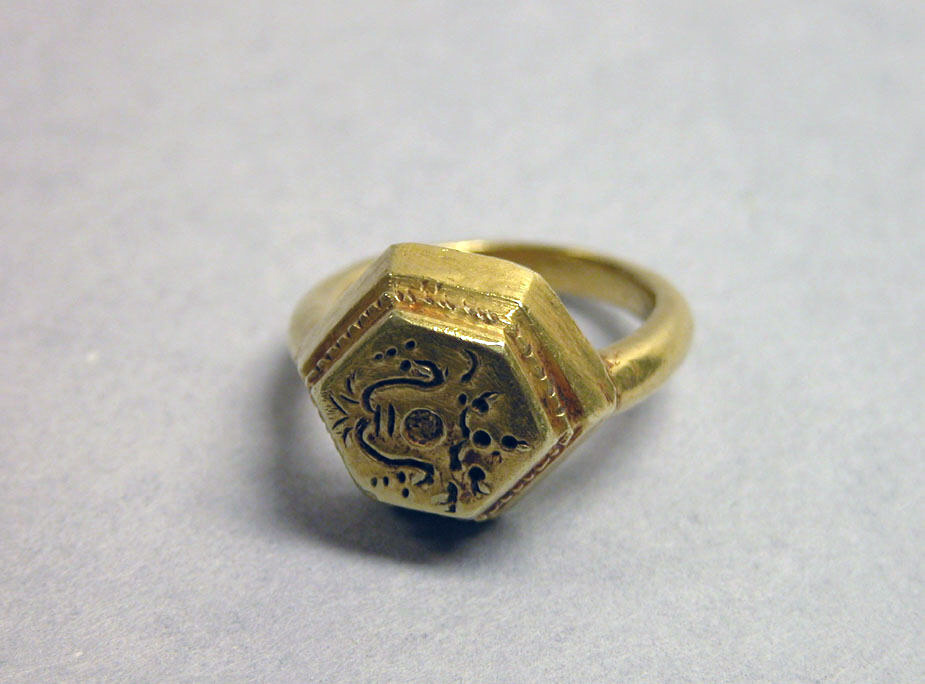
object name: ring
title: Ring with Hexagonal Bezel and "Sri" Inscription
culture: indonesian, javanese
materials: gold